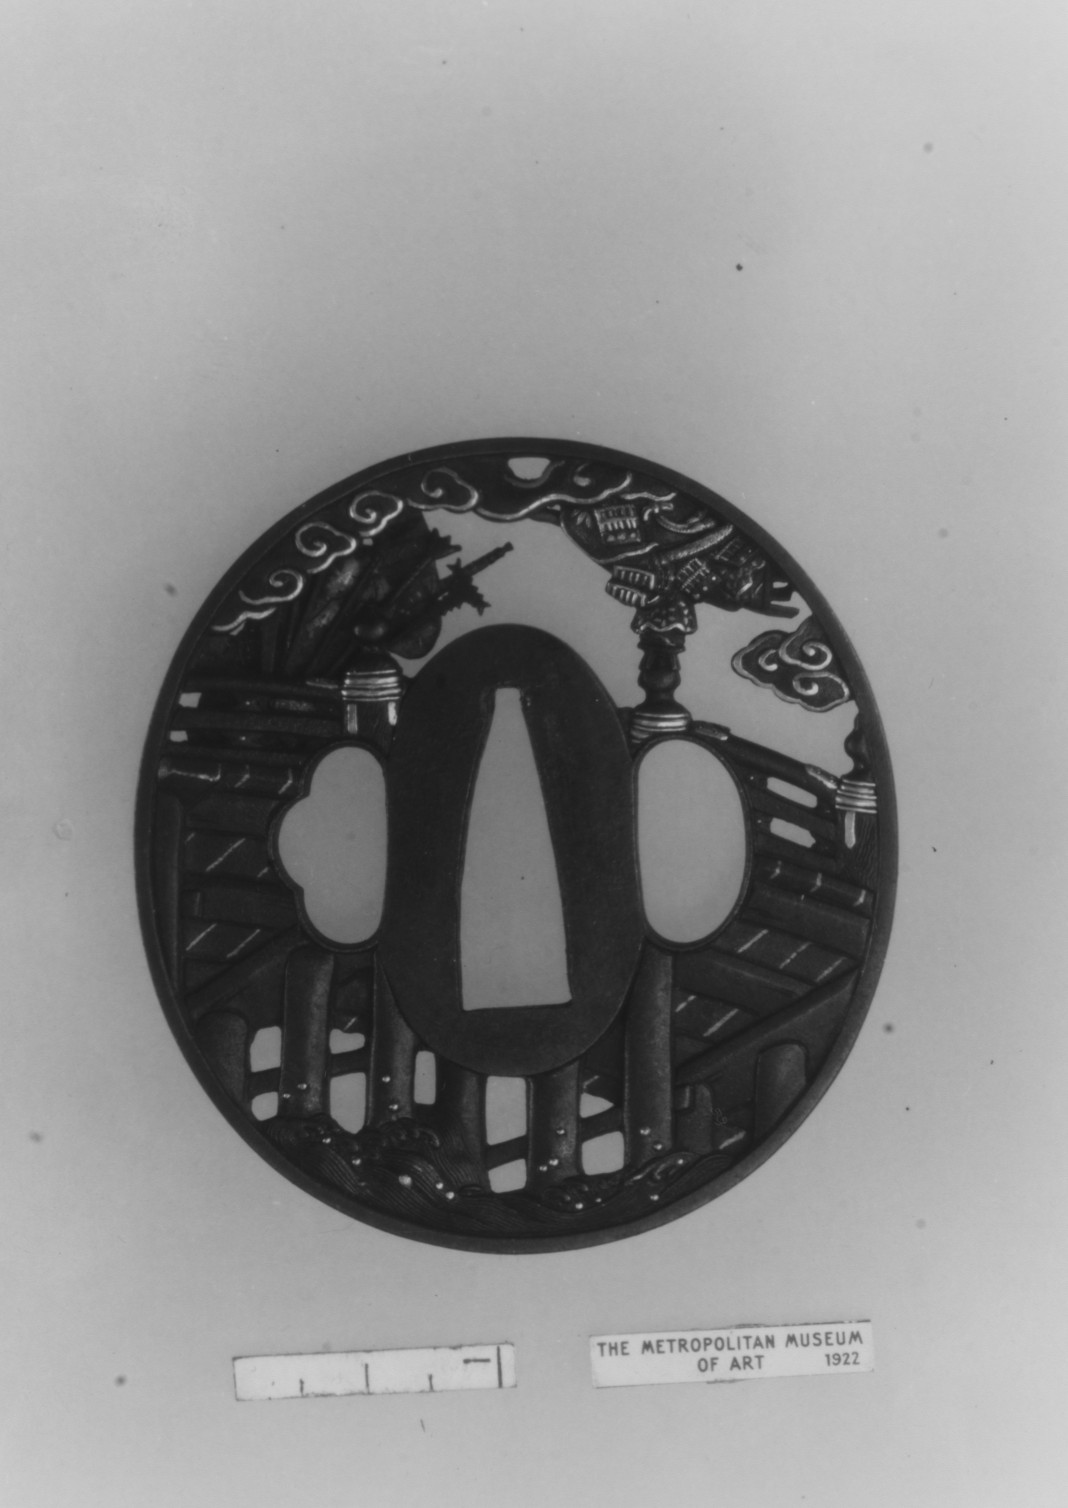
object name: sword guard tsuba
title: Sword Guard (Tsuba)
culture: japanese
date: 1701-1800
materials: copper, gold, iron, silver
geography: japan